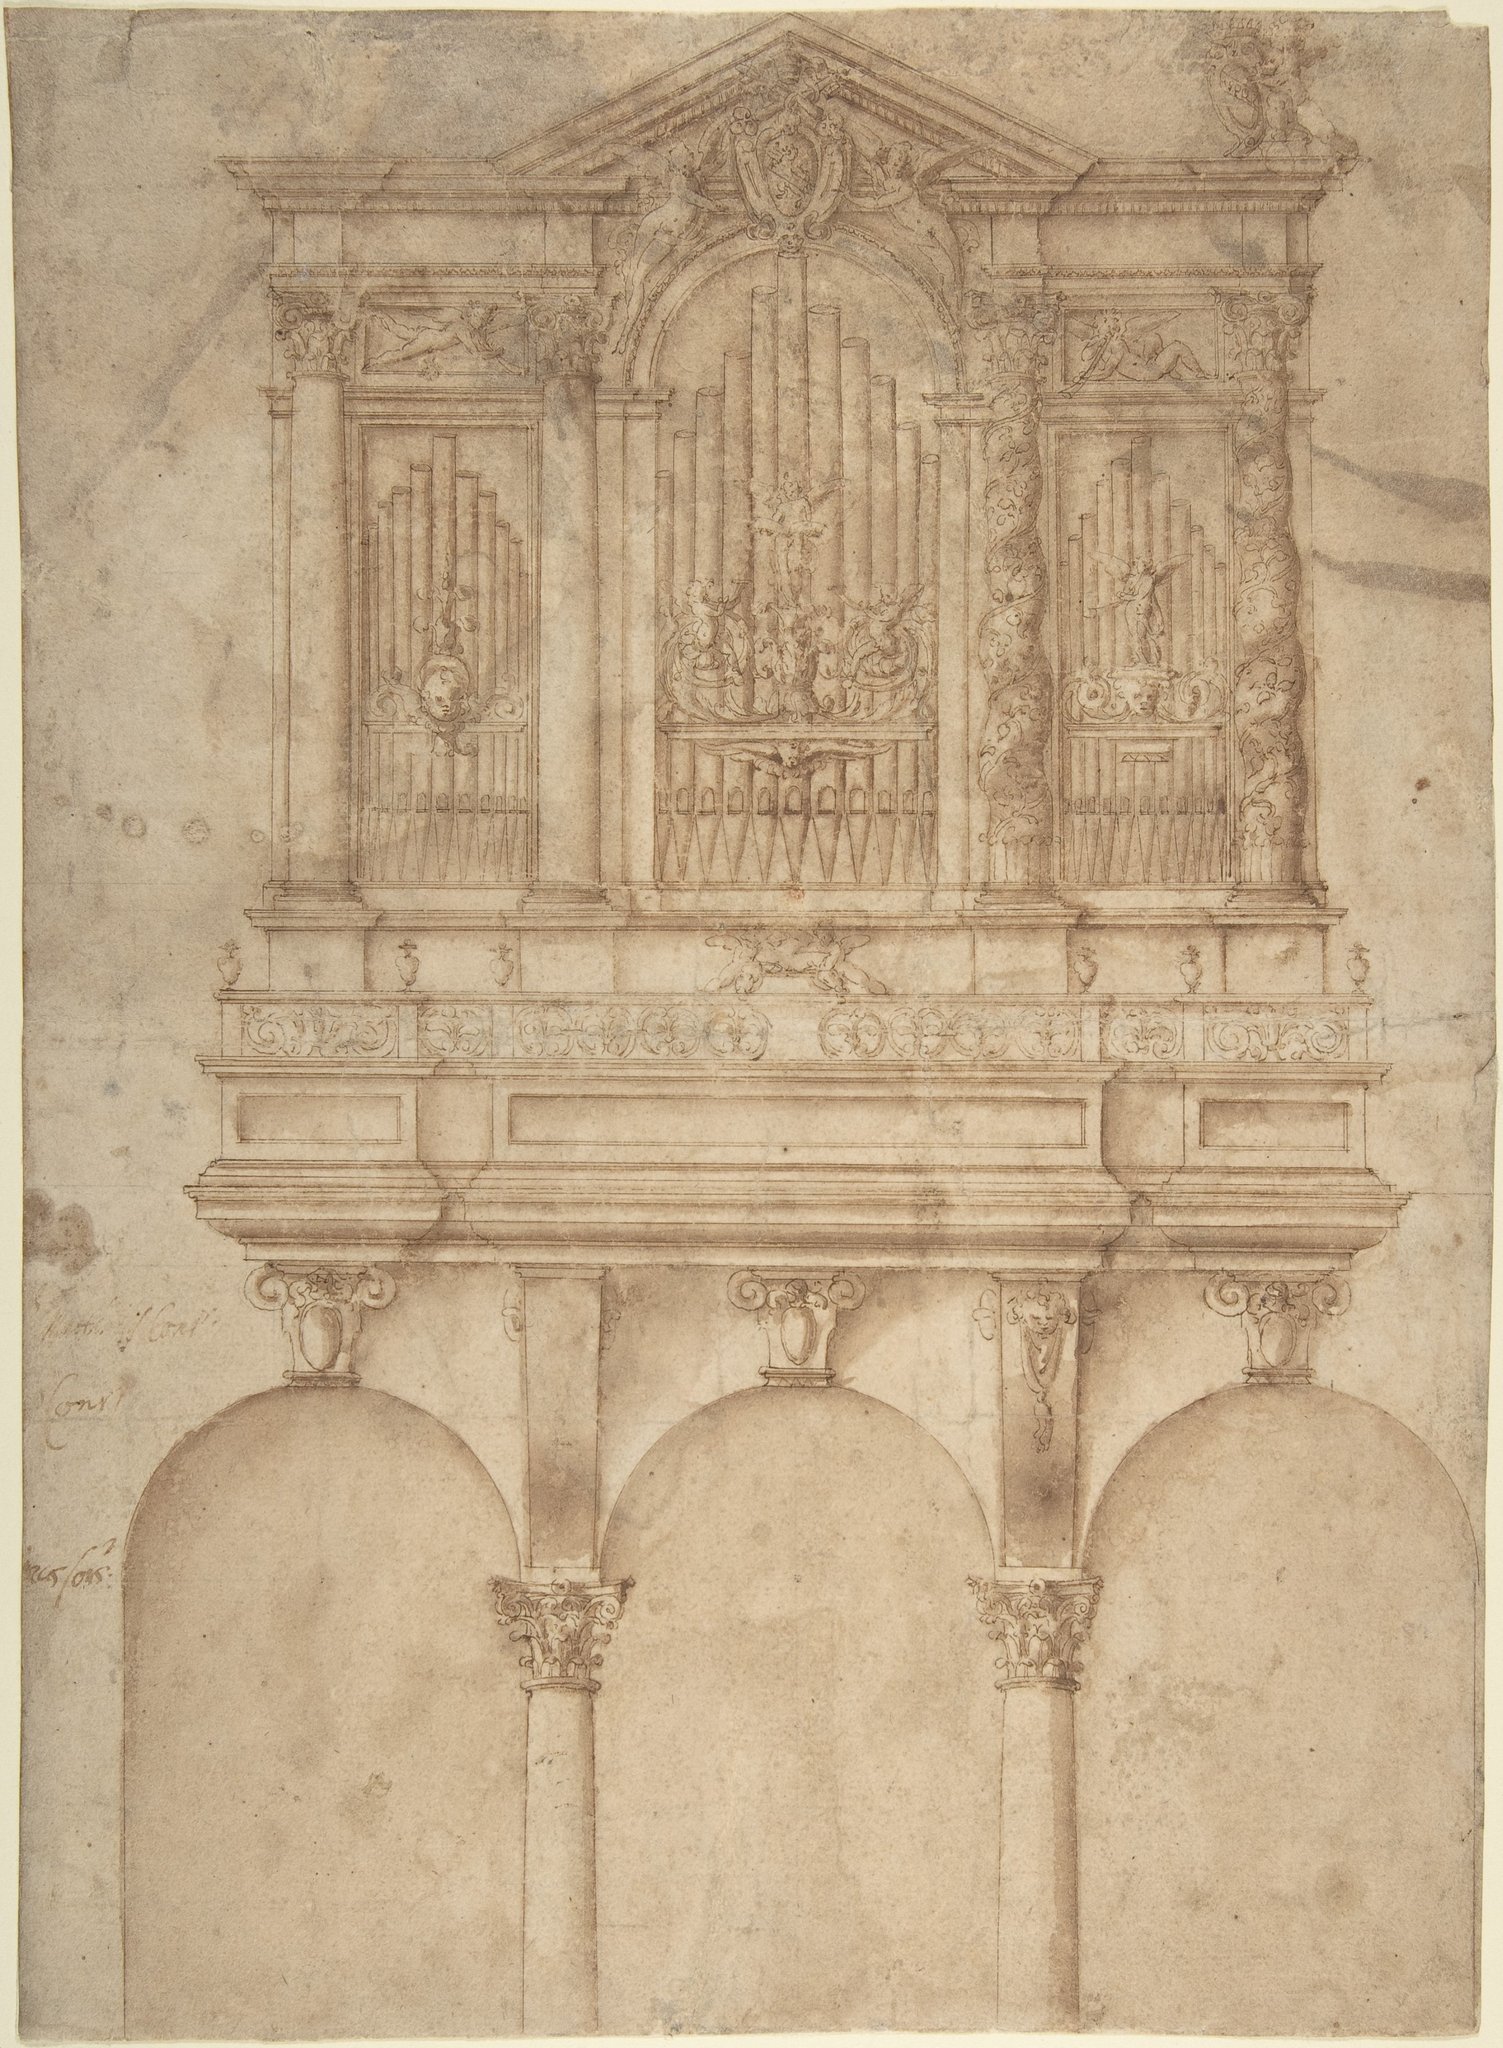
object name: drawing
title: A Pipe Organ with Papal Arms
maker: anonymous, italian, 16th century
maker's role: artist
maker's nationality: italian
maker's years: 1500-1600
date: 1501-1600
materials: ink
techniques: brush, pen, wash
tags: organs